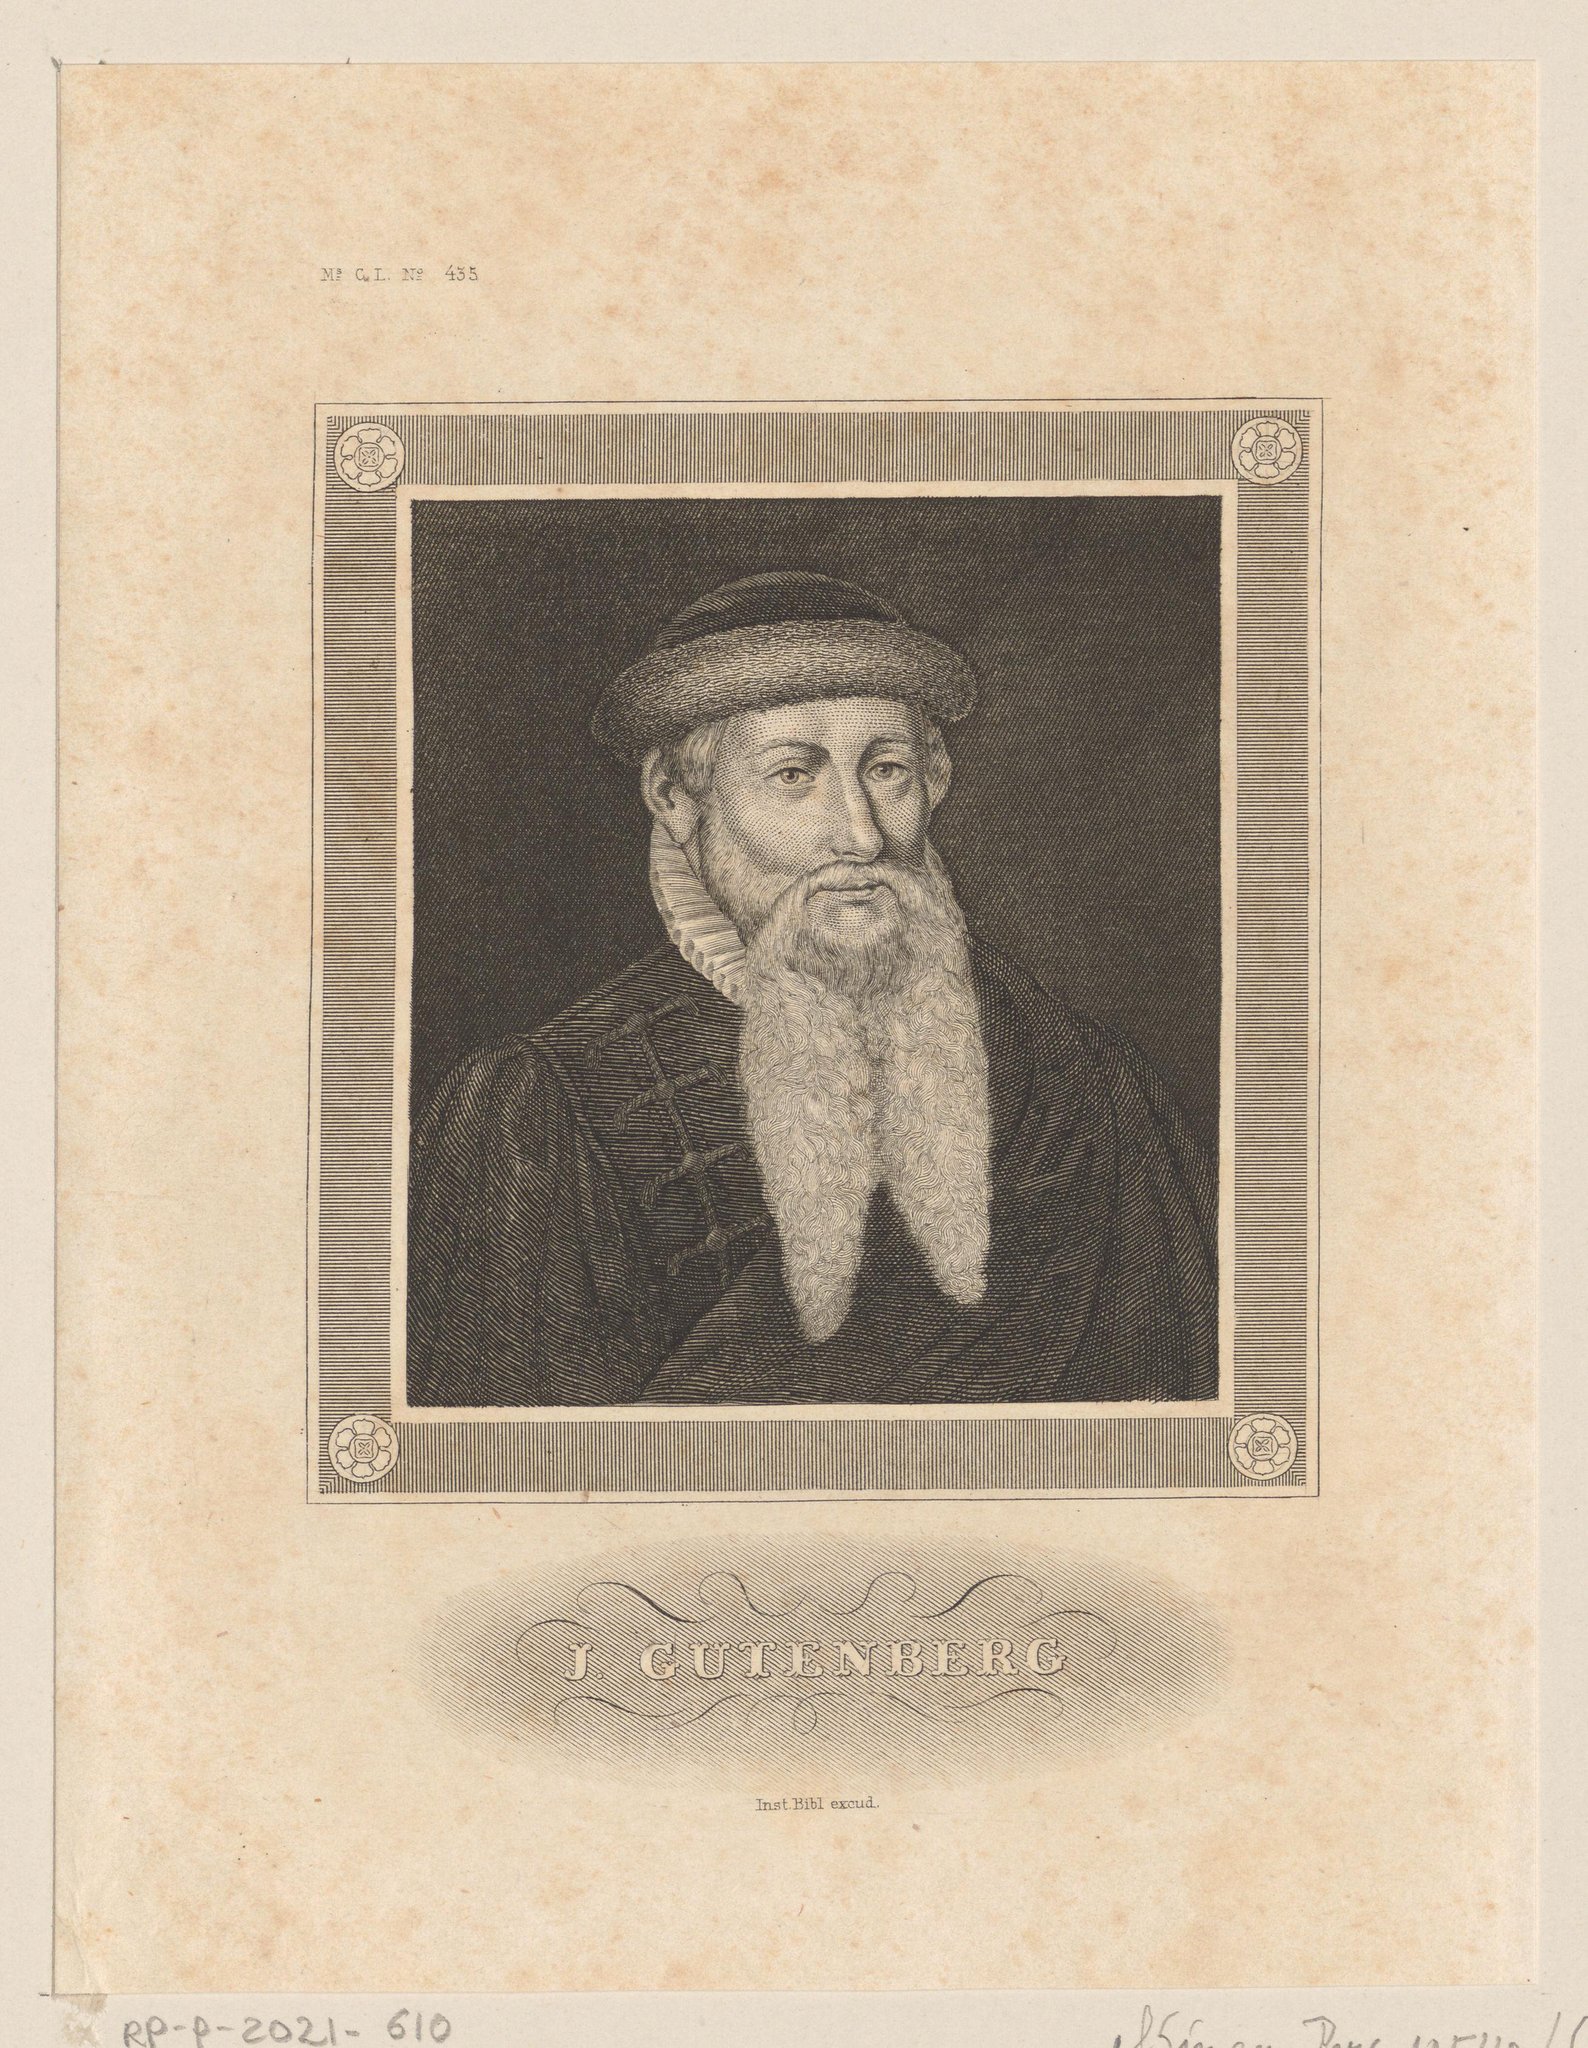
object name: book illustration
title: Portret van Johann Guttenberg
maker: Anonymous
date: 1828-1852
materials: paper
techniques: engraving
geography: hildburghausen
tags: printer, johannes gutenberg, publishing, publisher (+ portrait of scholar, scientist), historical persons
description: Prent uit: Meyer, Joseph. Das große Conversations-Lexikon für die gebildeten Stände. 52 dln. Hildburghausen: Bibliographisches Institut, [1828-1852].